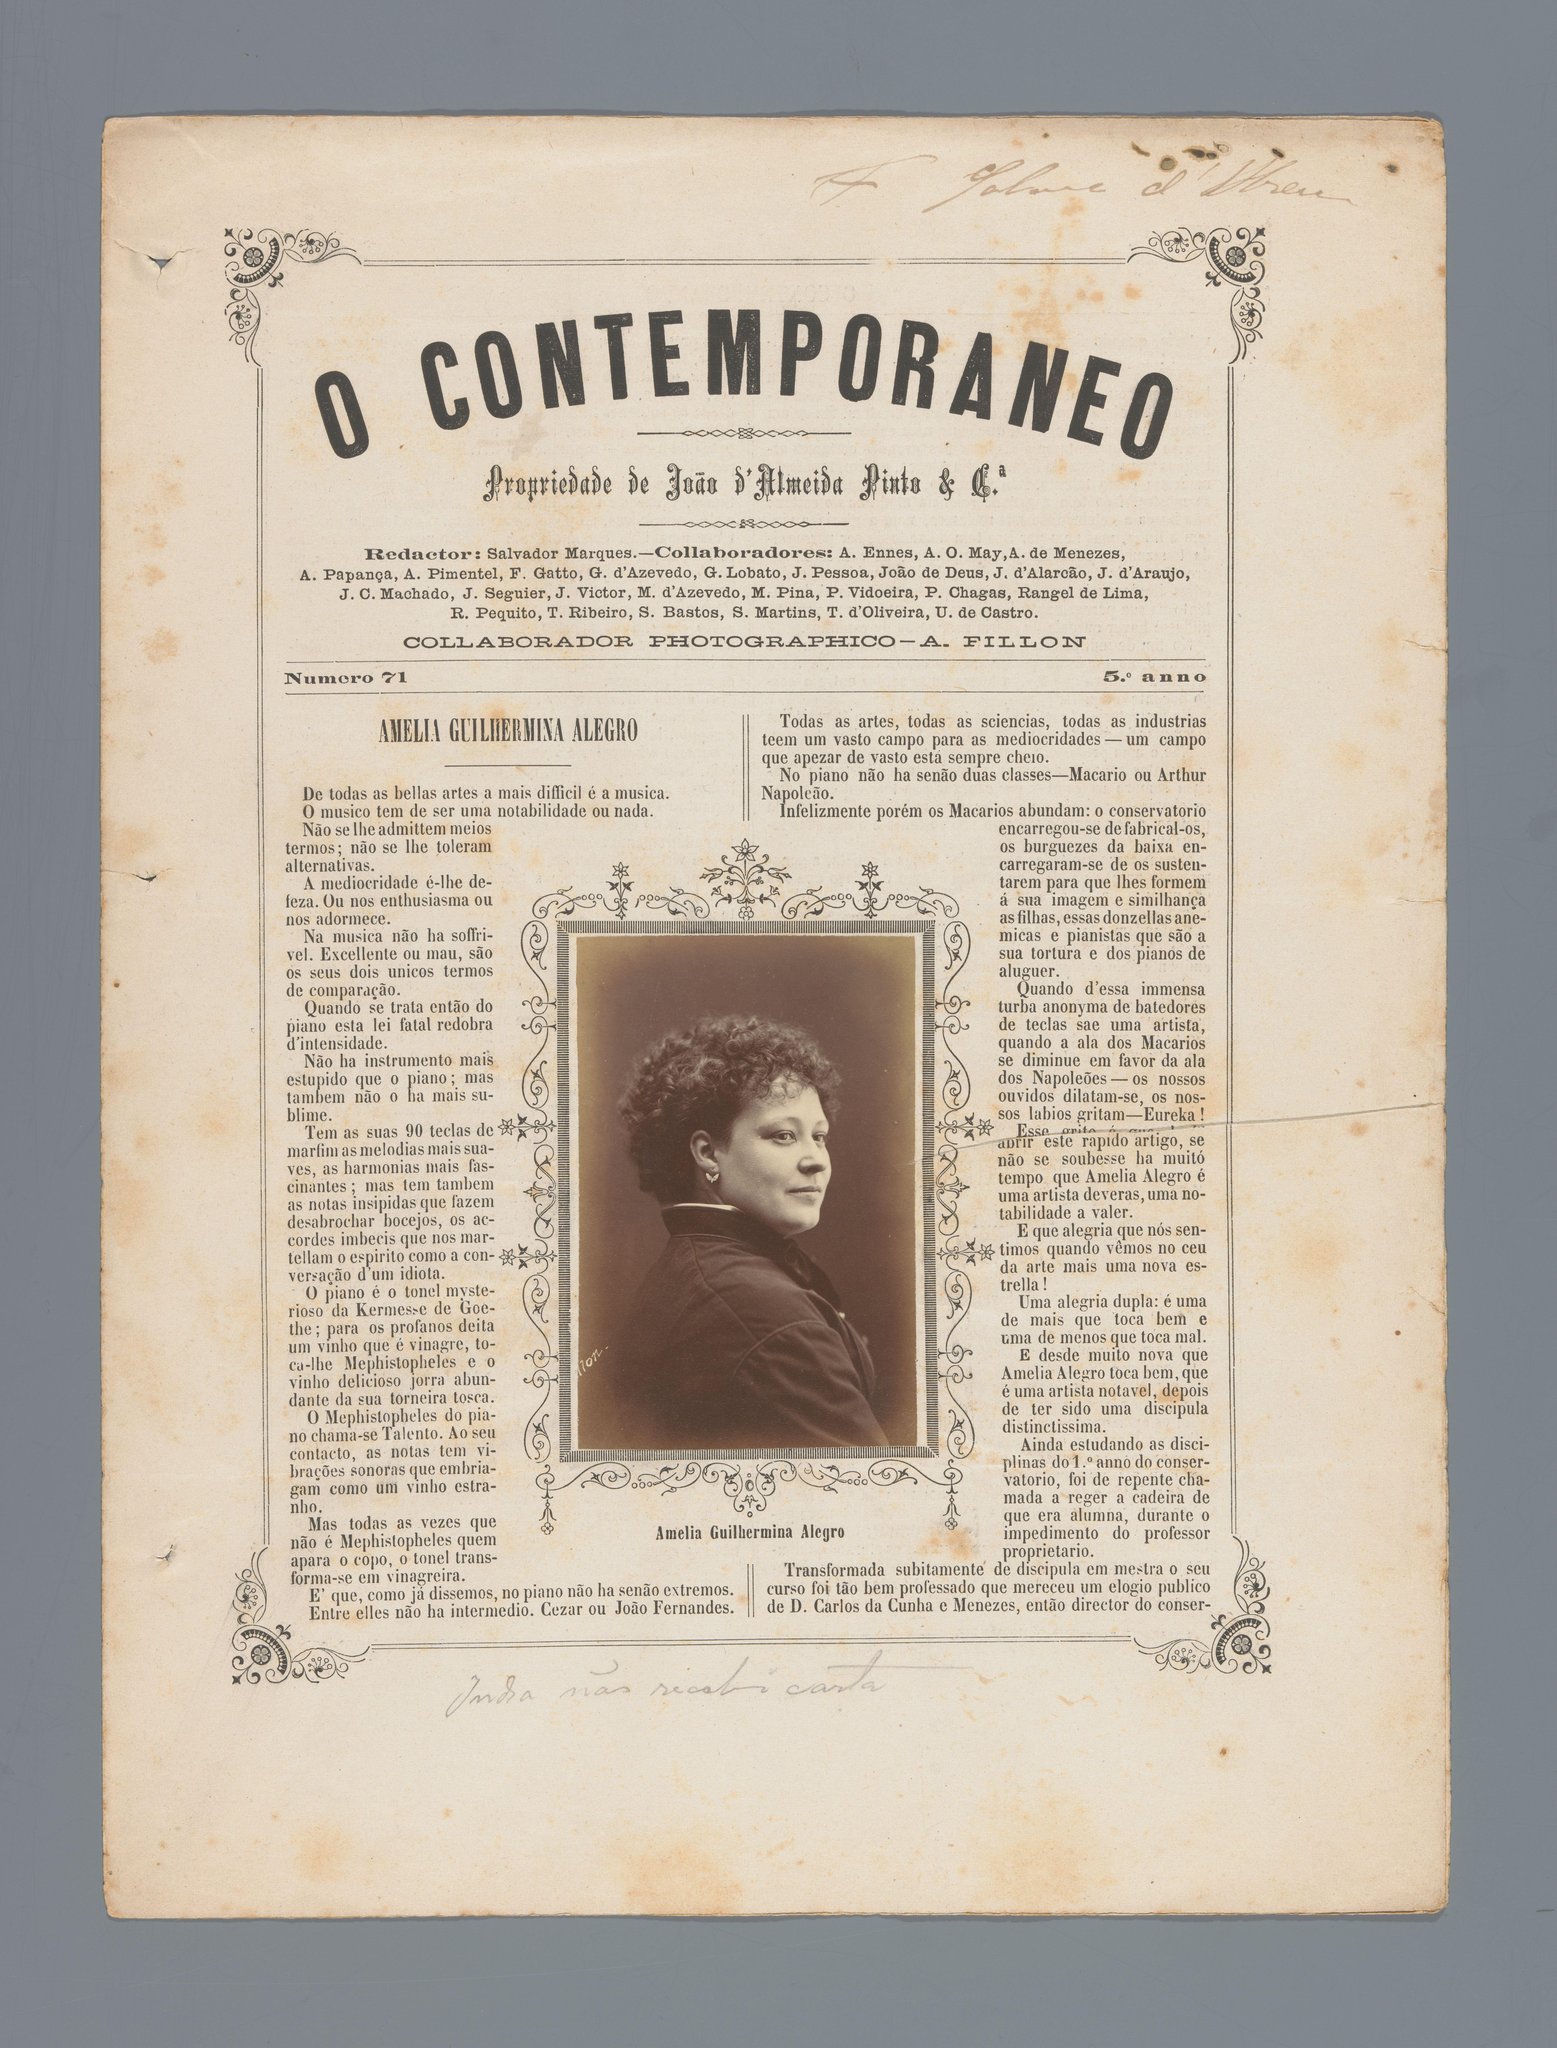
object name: photograph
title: O contemporaneo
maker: alfred fillon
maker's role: fotograaf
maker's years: 1825-1881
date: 1874-1879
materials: paper, photographic support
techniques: albumen print, printing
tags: historical persons - bb - woman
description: Op de voorpagina bevindt zich een portret van Amelia Guilhermina Alegro.